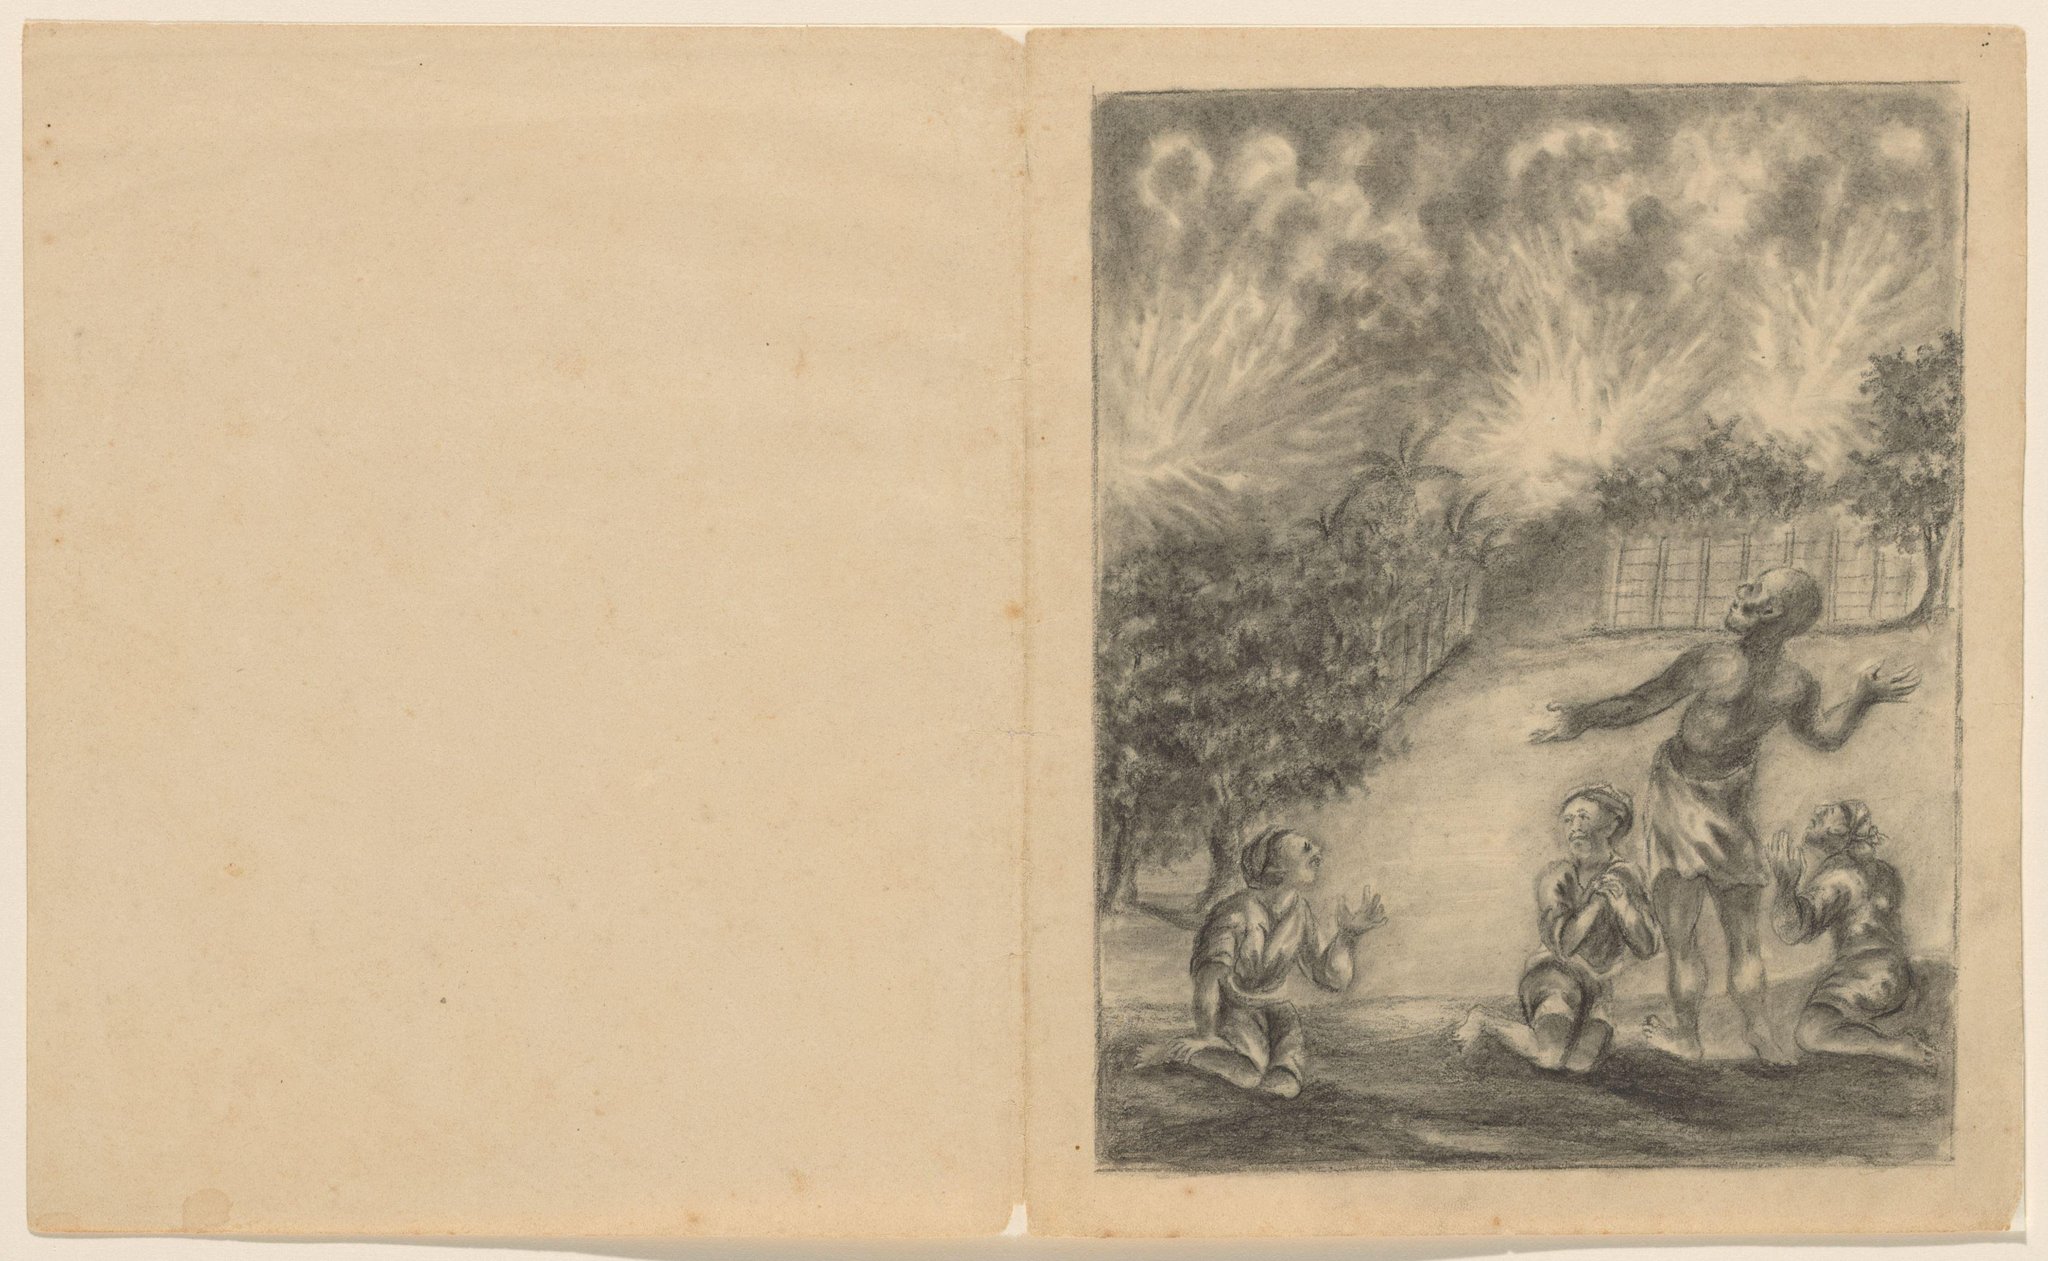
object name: drawing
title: Uitbarsting van de vulkaan Kelud, ca. 1820-1850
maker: Anonymous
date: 1850-1950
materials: chalk, paper, pencil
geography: indonesia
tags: eruption (of volcano)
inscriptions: collector's mark: Lugt 2228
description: De mensen in angst tijdens de vulkaanuitbarsting van de Kelud. Onderdeel van een groep van twaalf losse bladen uit een schetsboek met tekeningen over het leven van Coenraad Laurens Coolen, evangelist op Oost-Java, ca. 1820-1850. Elk blad heeft een tekening op de rechterhelft, met een onderschrift in het Indonesisch.